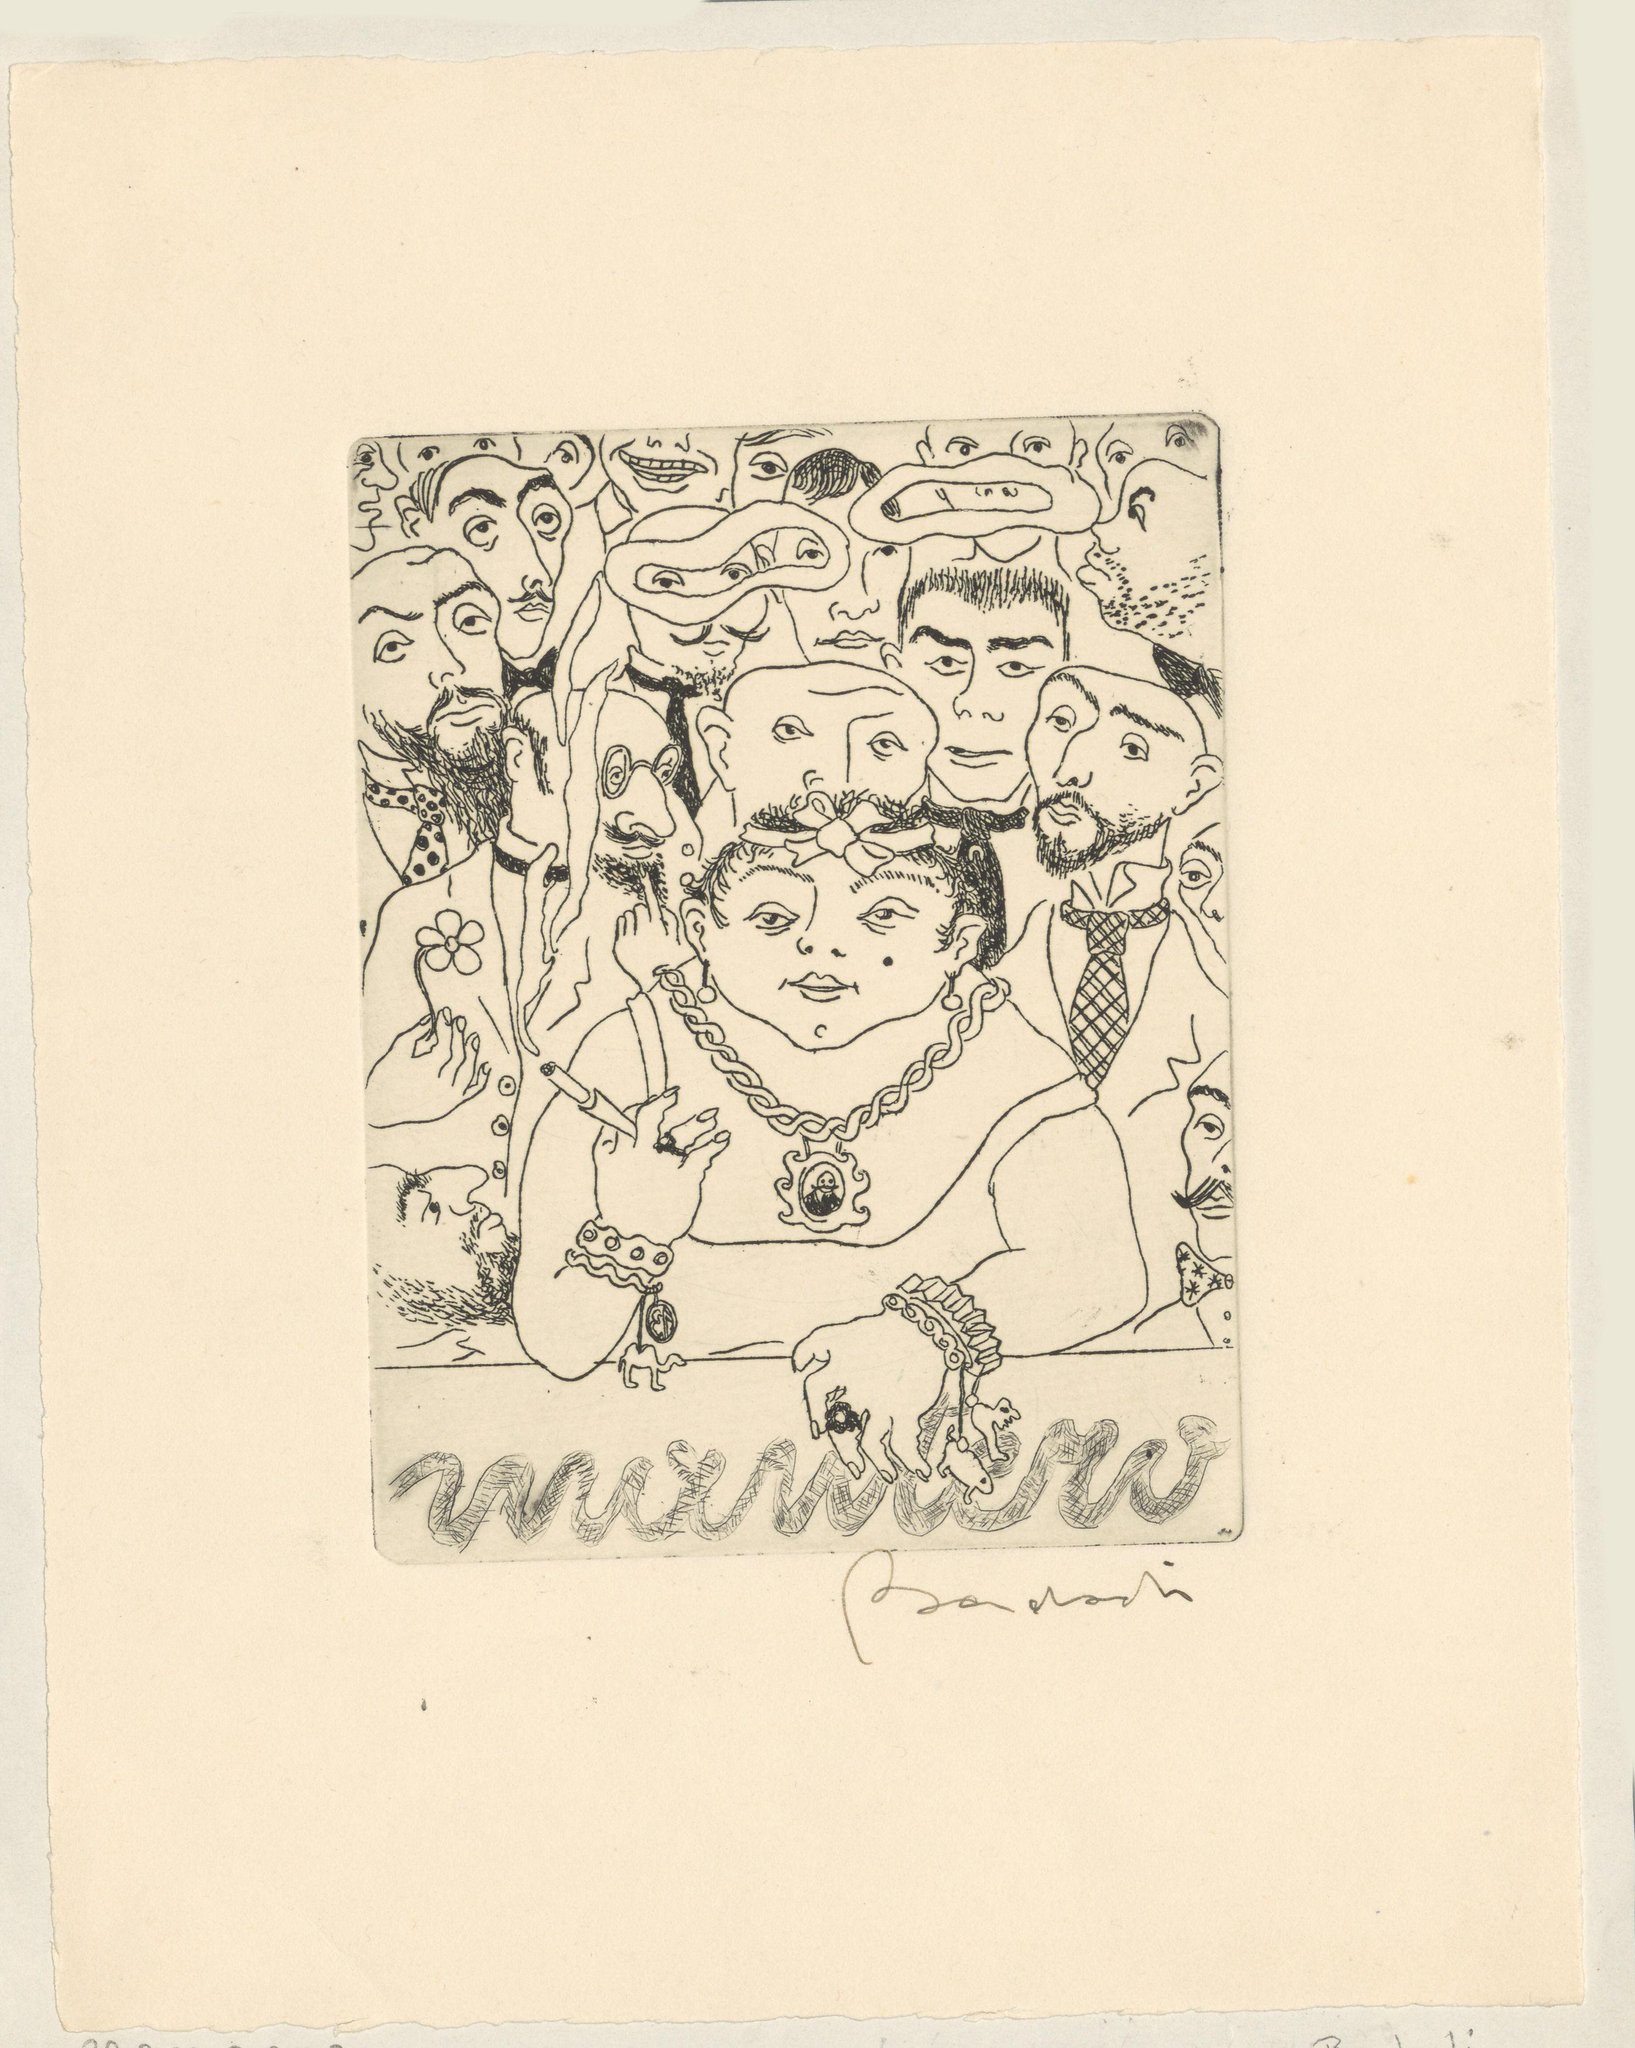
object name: bookplate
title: Ex libris van Mantero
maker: arnaldo badodi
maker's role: painter, print maker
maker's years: 1913-1943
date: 1938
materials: paper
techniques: etching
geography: milan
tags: engineer, gianni mantero, crowd, mob, cigarette, ornaments, jewels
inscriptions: signature: ‘Badodi’, workshop stamp: ‘A. Badodi / Milano 1938 / Aquaforte - eaux forte / Radierung’